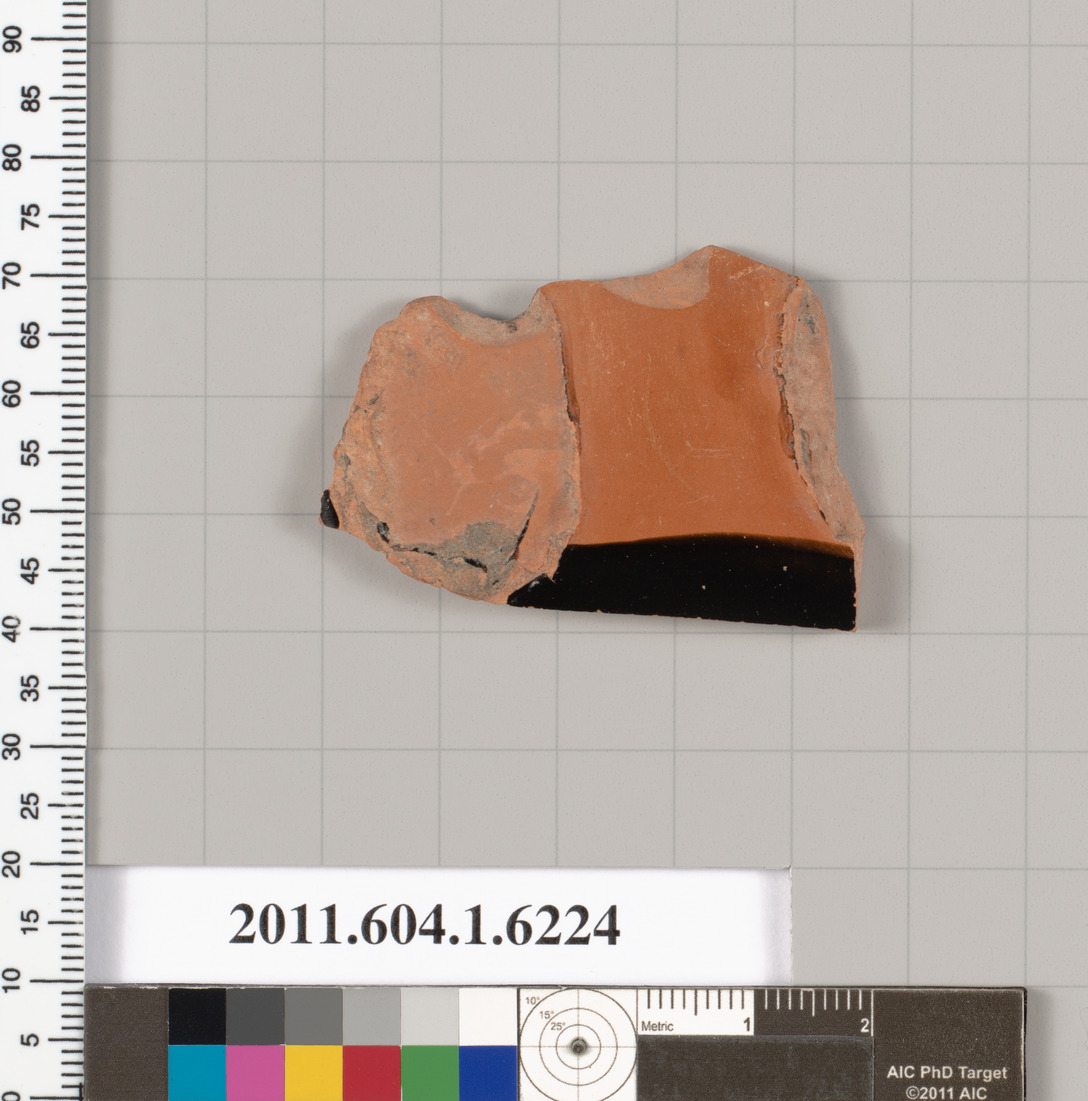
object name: kylix fragment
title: Terracotta fragment of a kylix (drinking cup)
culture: greek, attic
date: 510-500 BCE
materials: terracotta